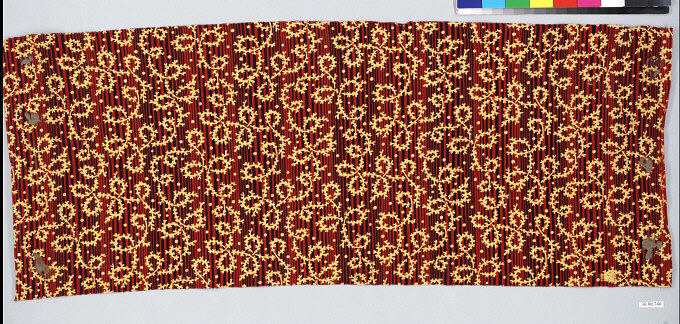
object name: piece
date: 1867-1900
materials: cotton